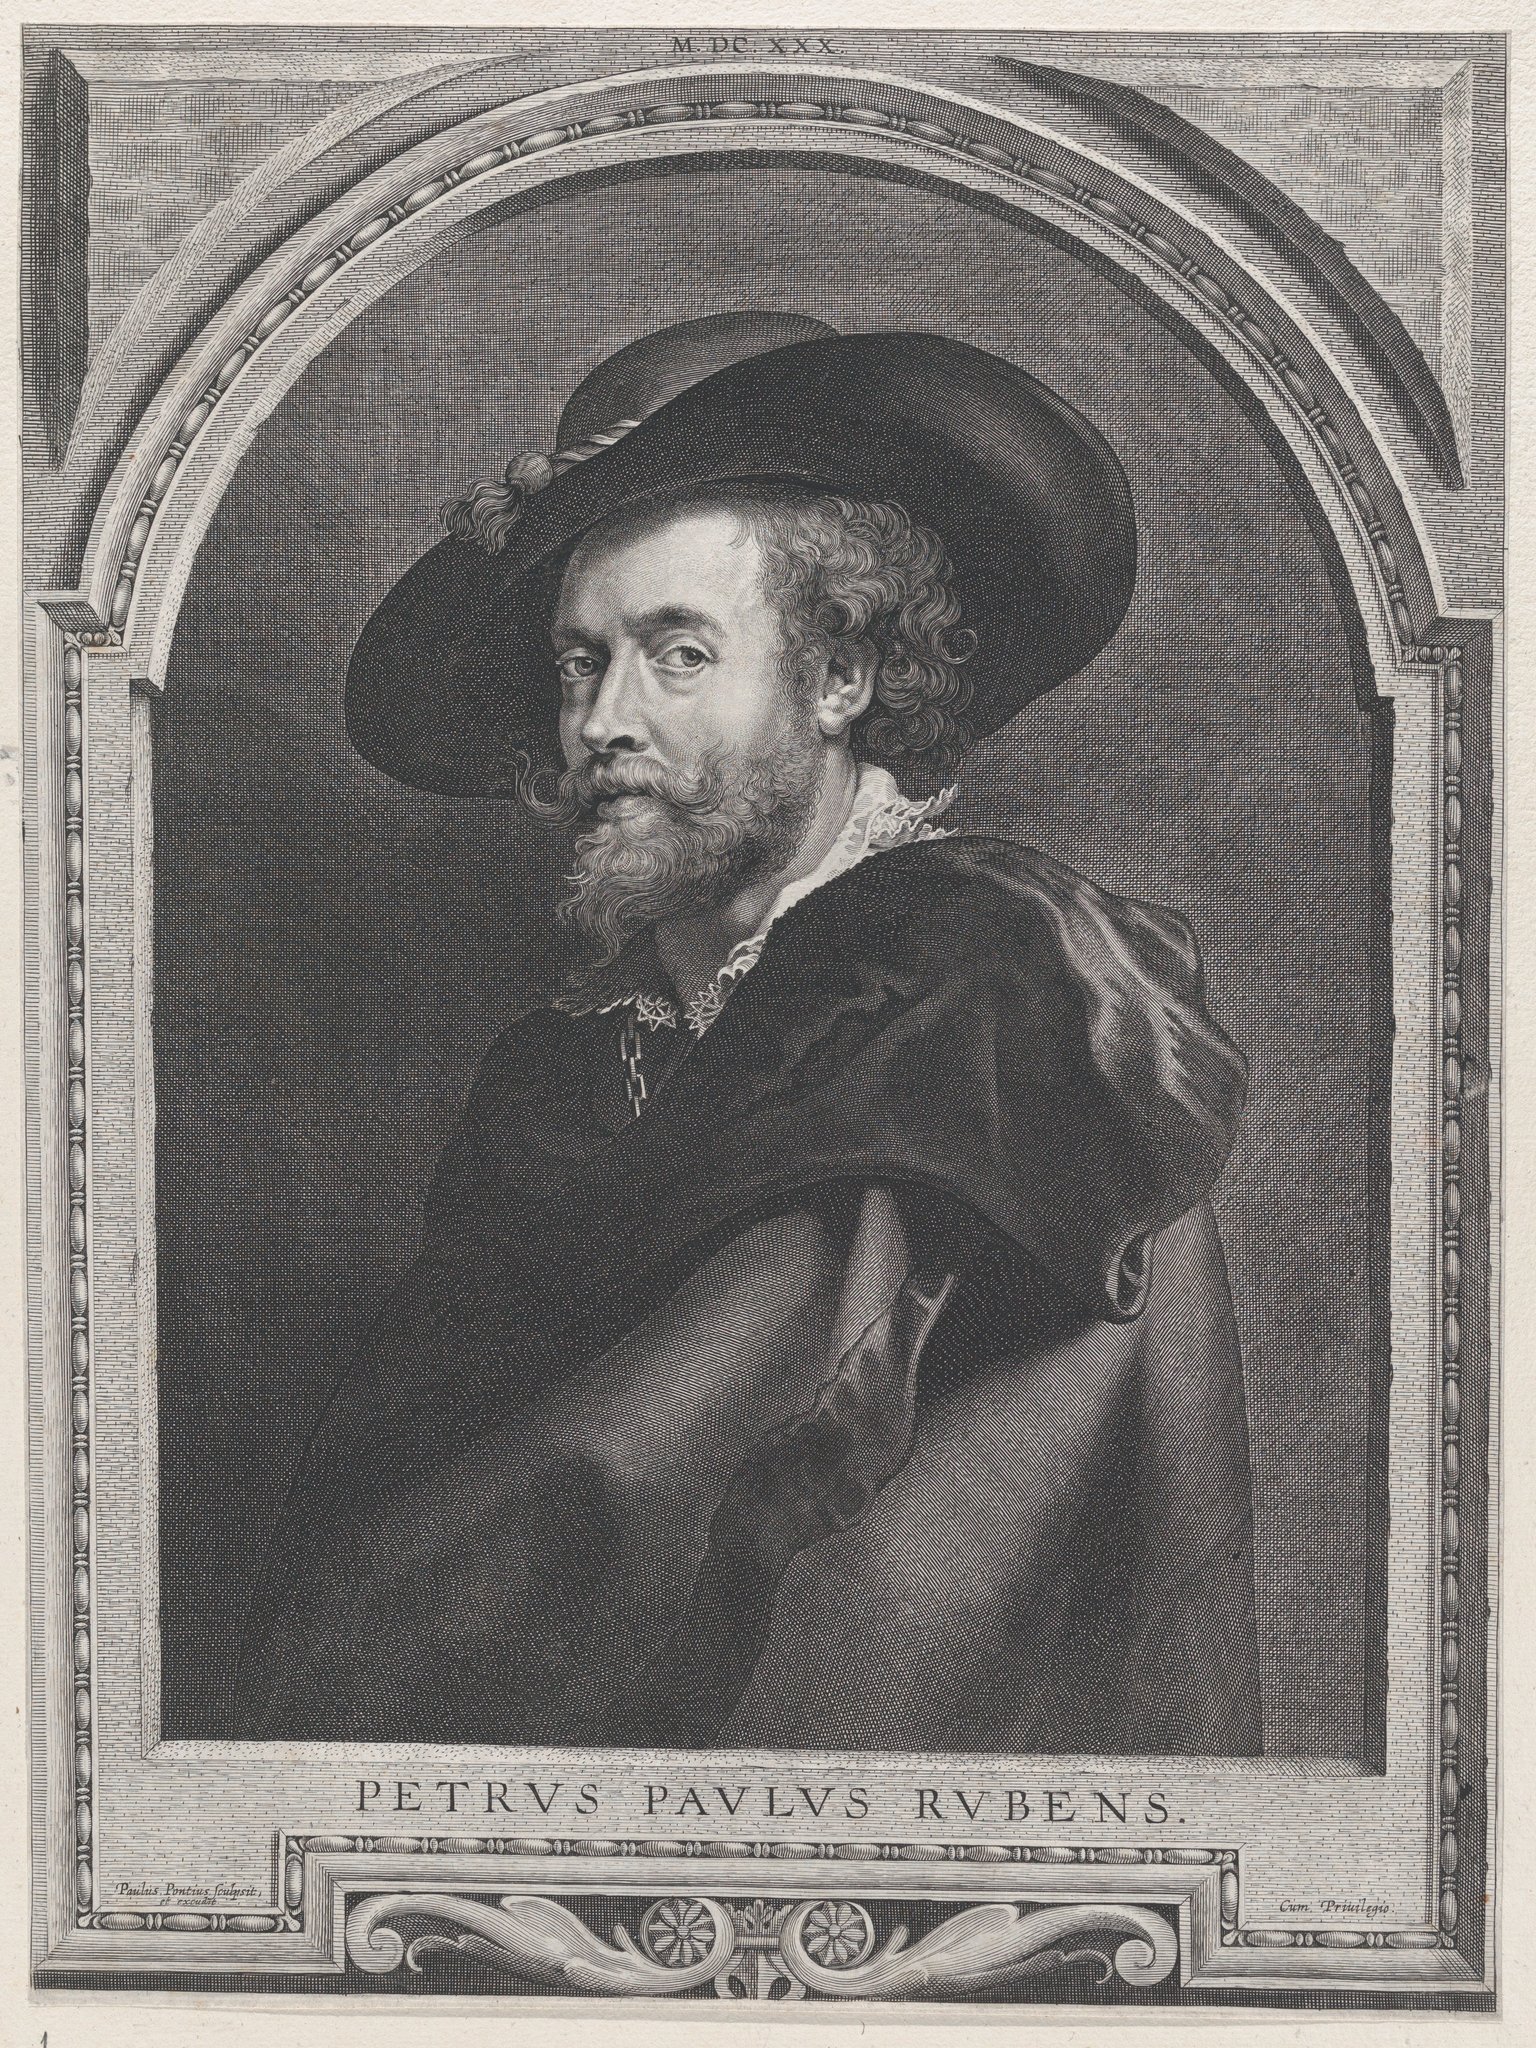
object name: print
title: Portrait of Peter Paul Rubens, aged 46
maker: paulus pontius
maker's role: artist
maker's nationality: flemish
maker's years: 1603-1658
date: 1630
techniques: engraving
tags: men,portraits